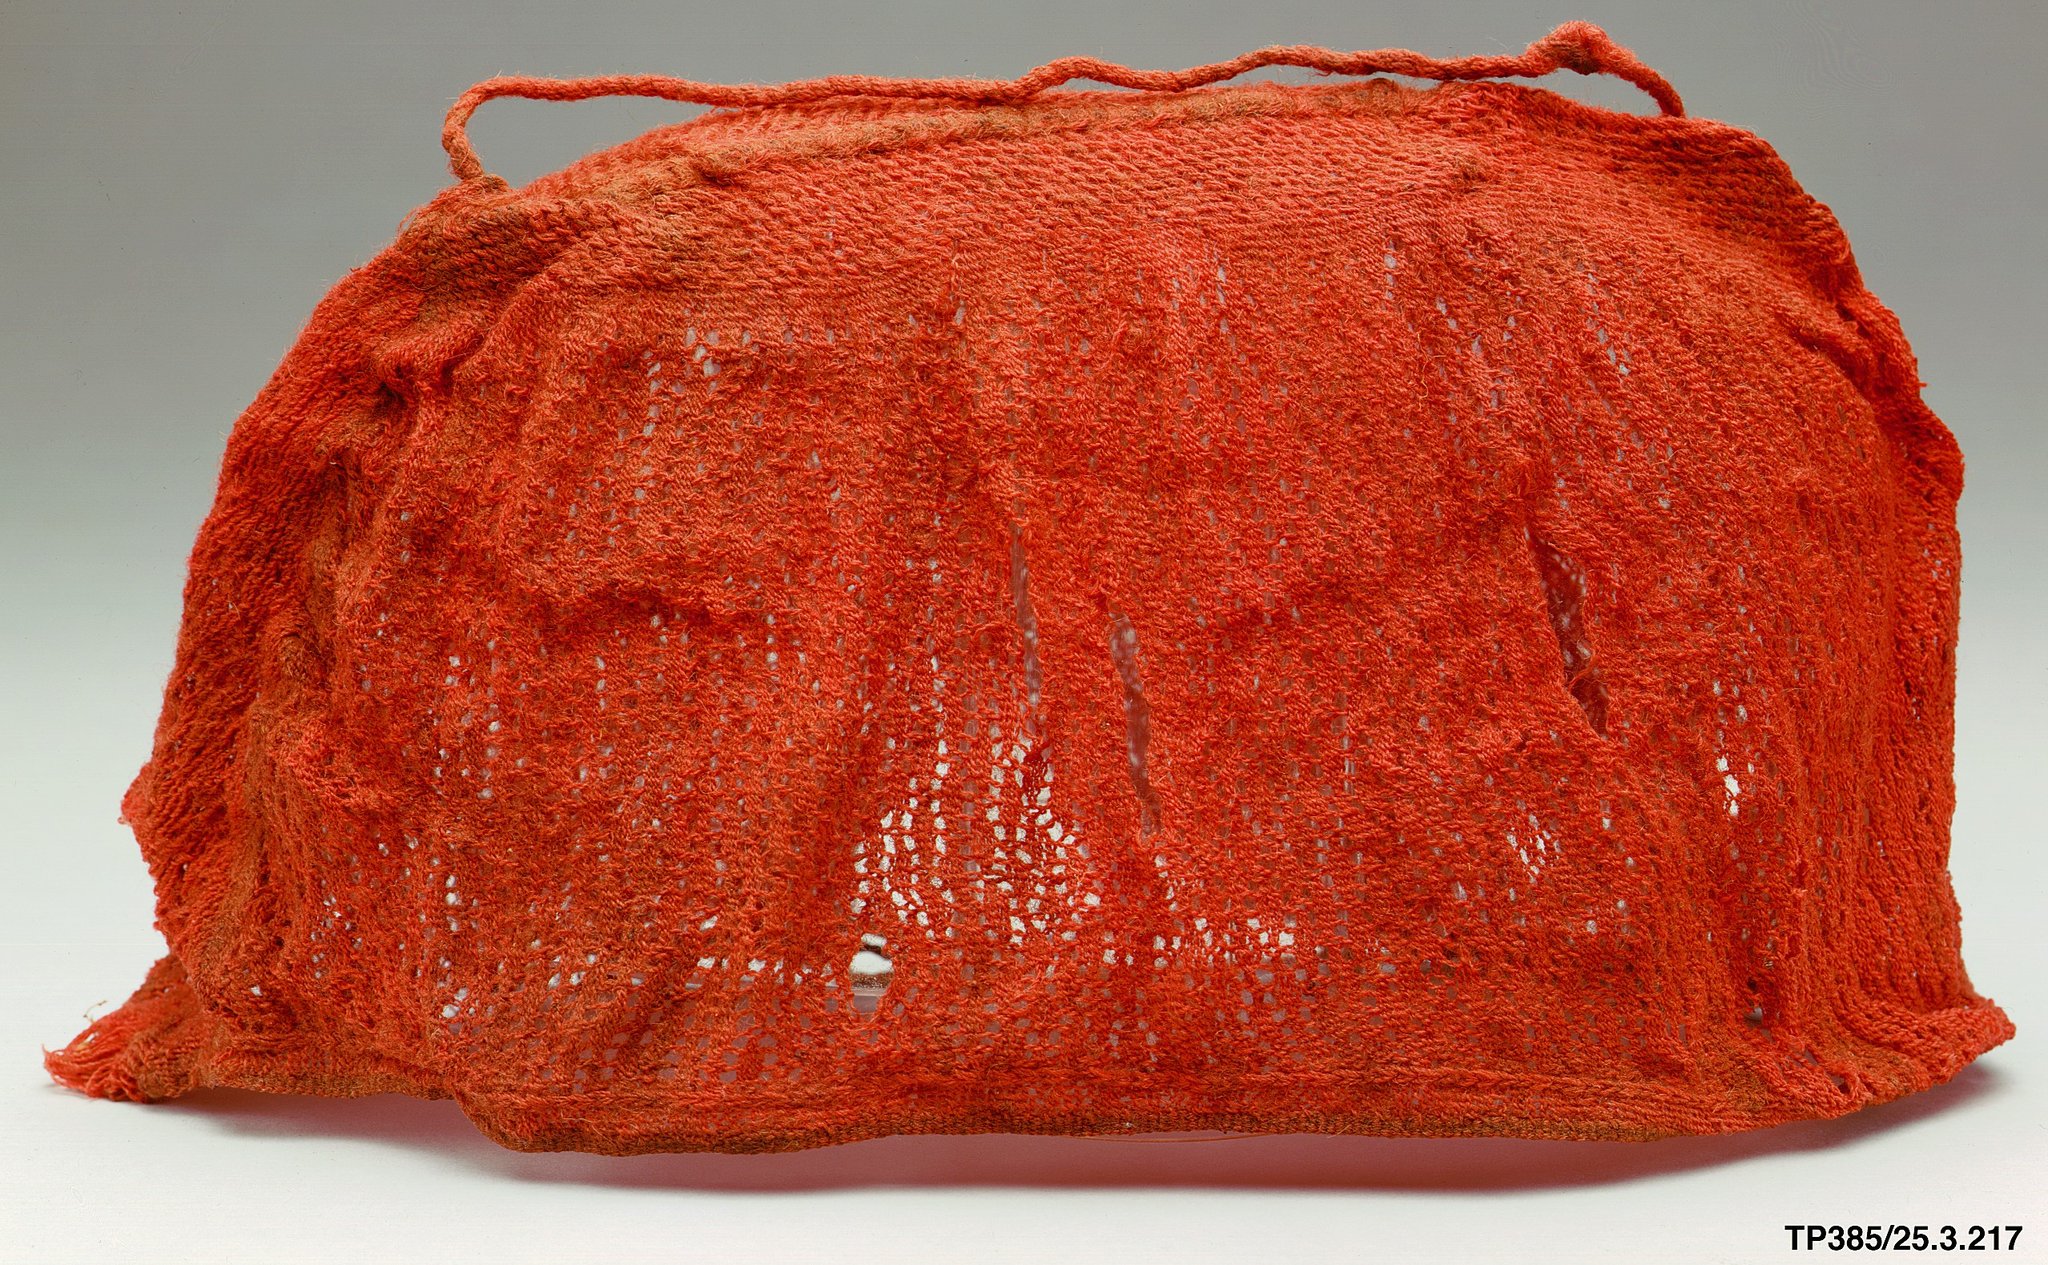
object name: cap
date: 101-333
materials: wool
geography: egypt